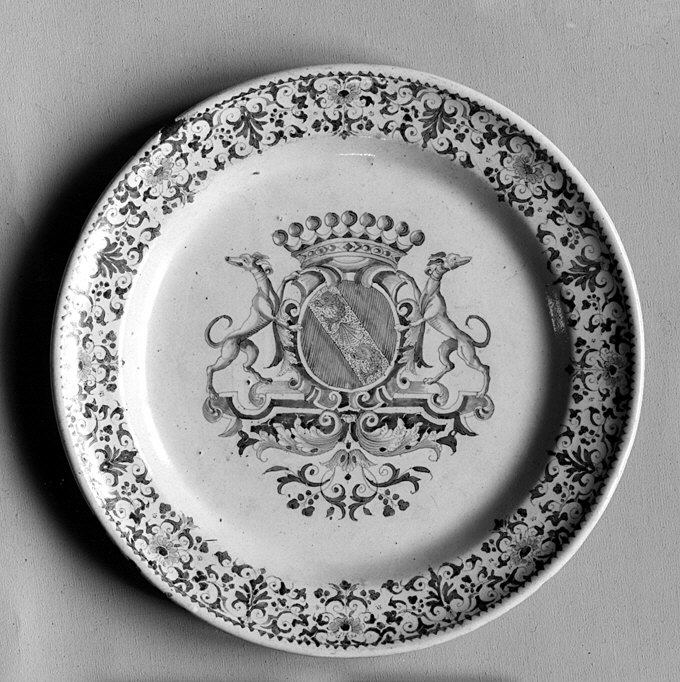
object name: plate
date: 1701-1733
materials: faience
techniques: glazing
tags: coat of arms